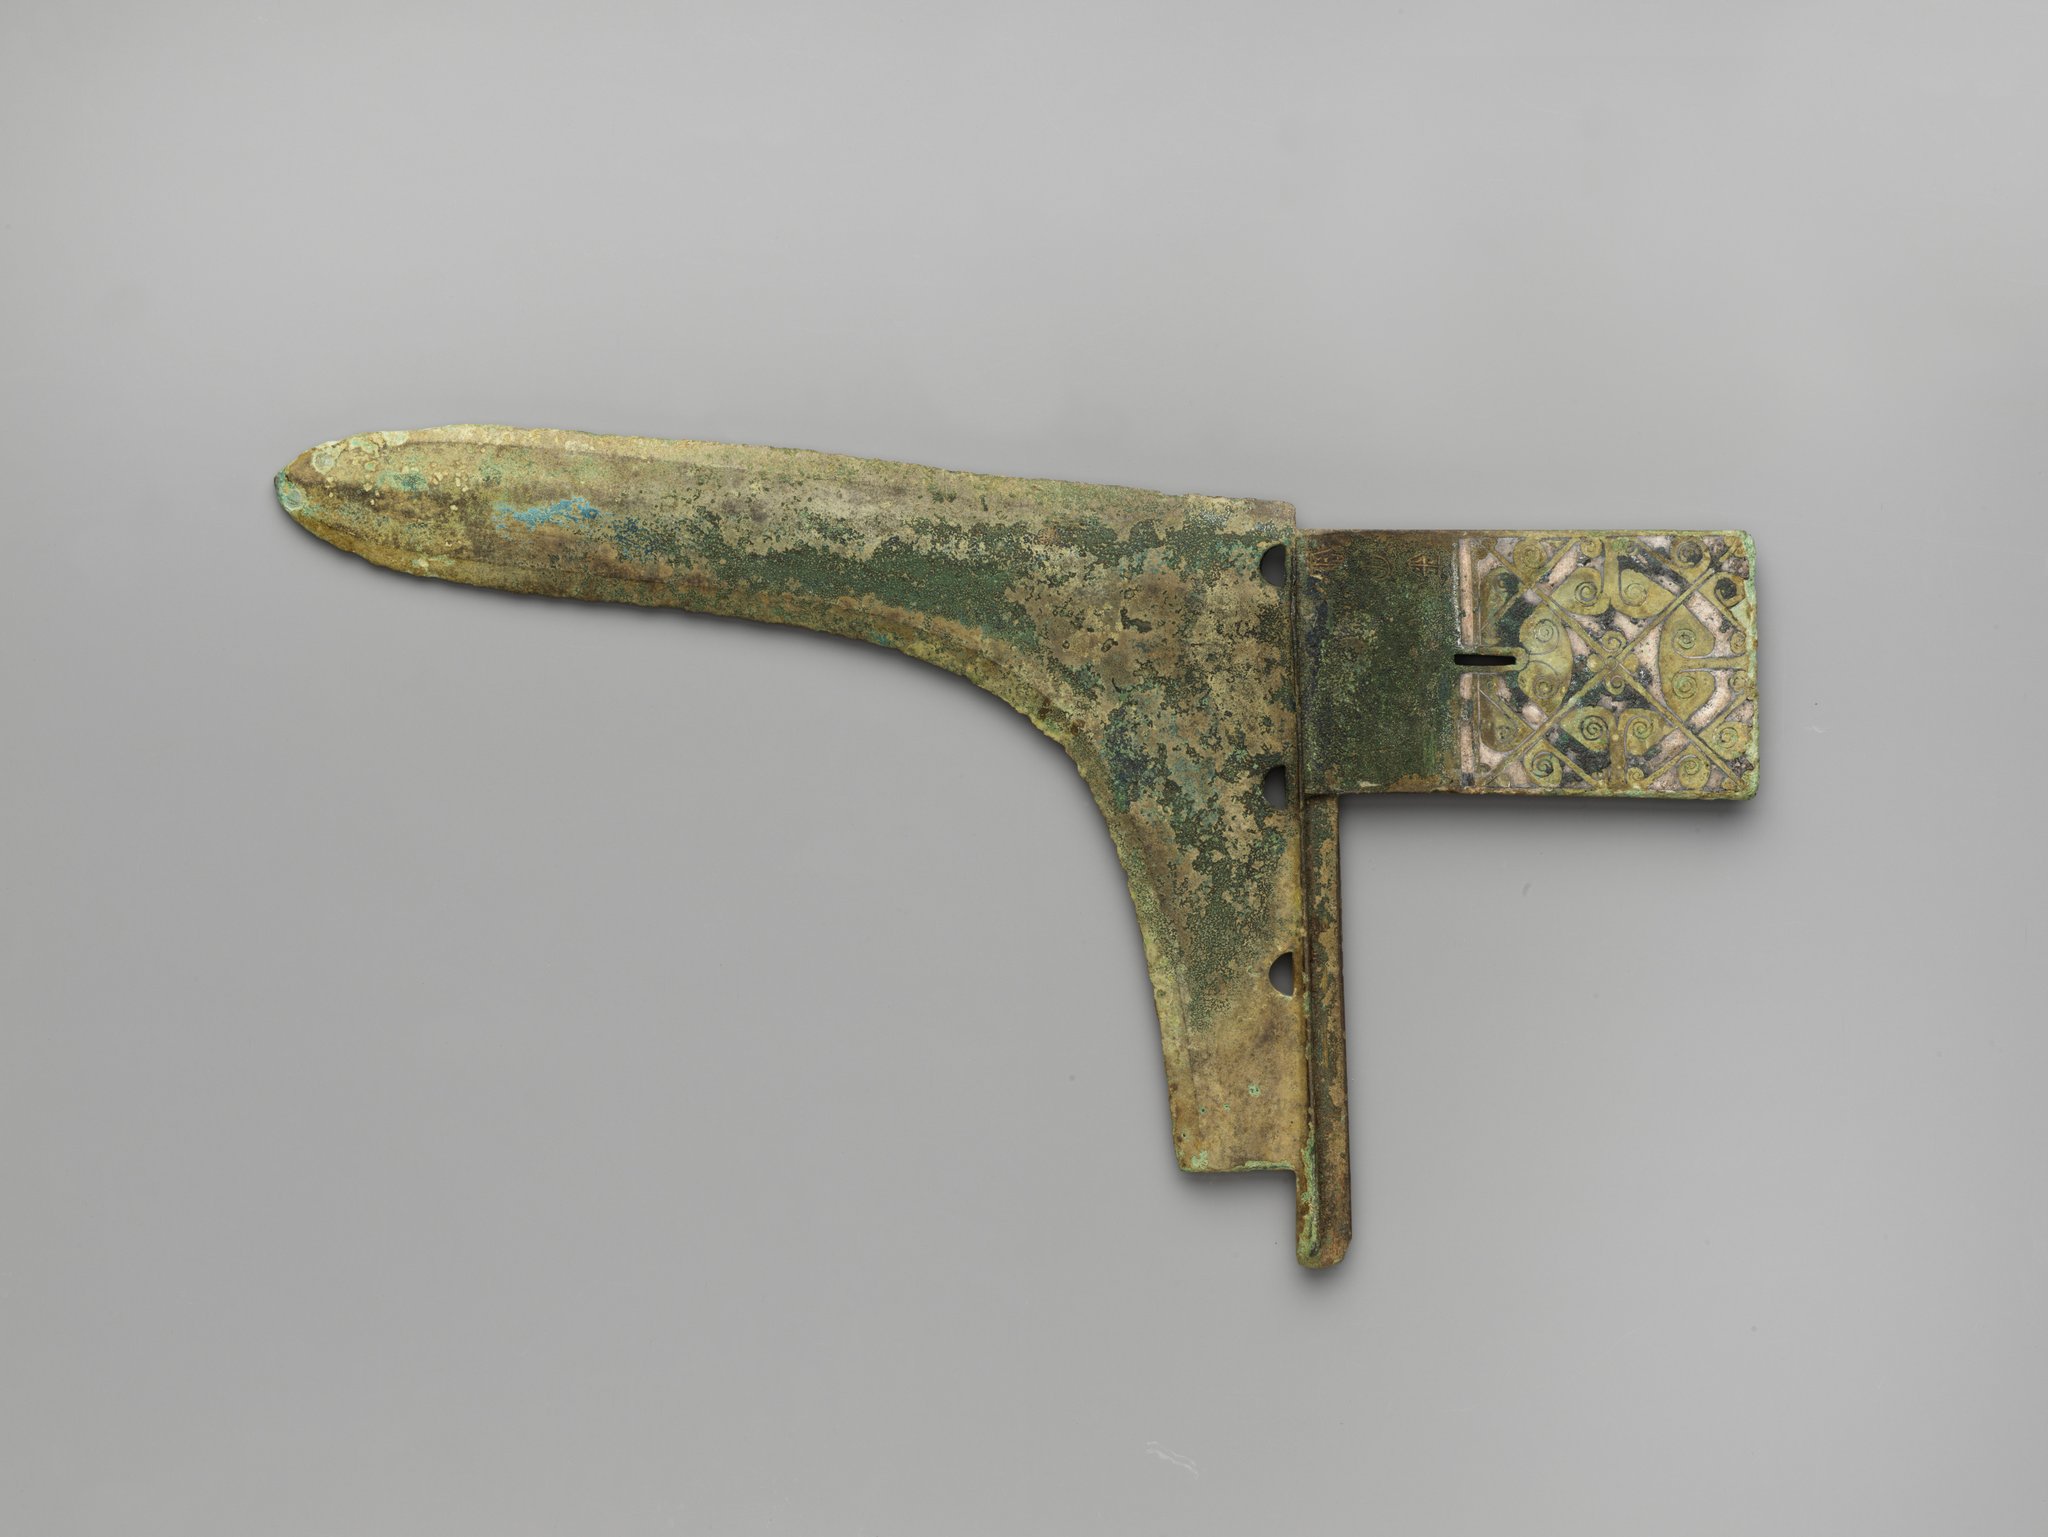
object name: halberd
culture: chinese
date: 600-401 BCE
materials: bronze, silver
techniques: inlay